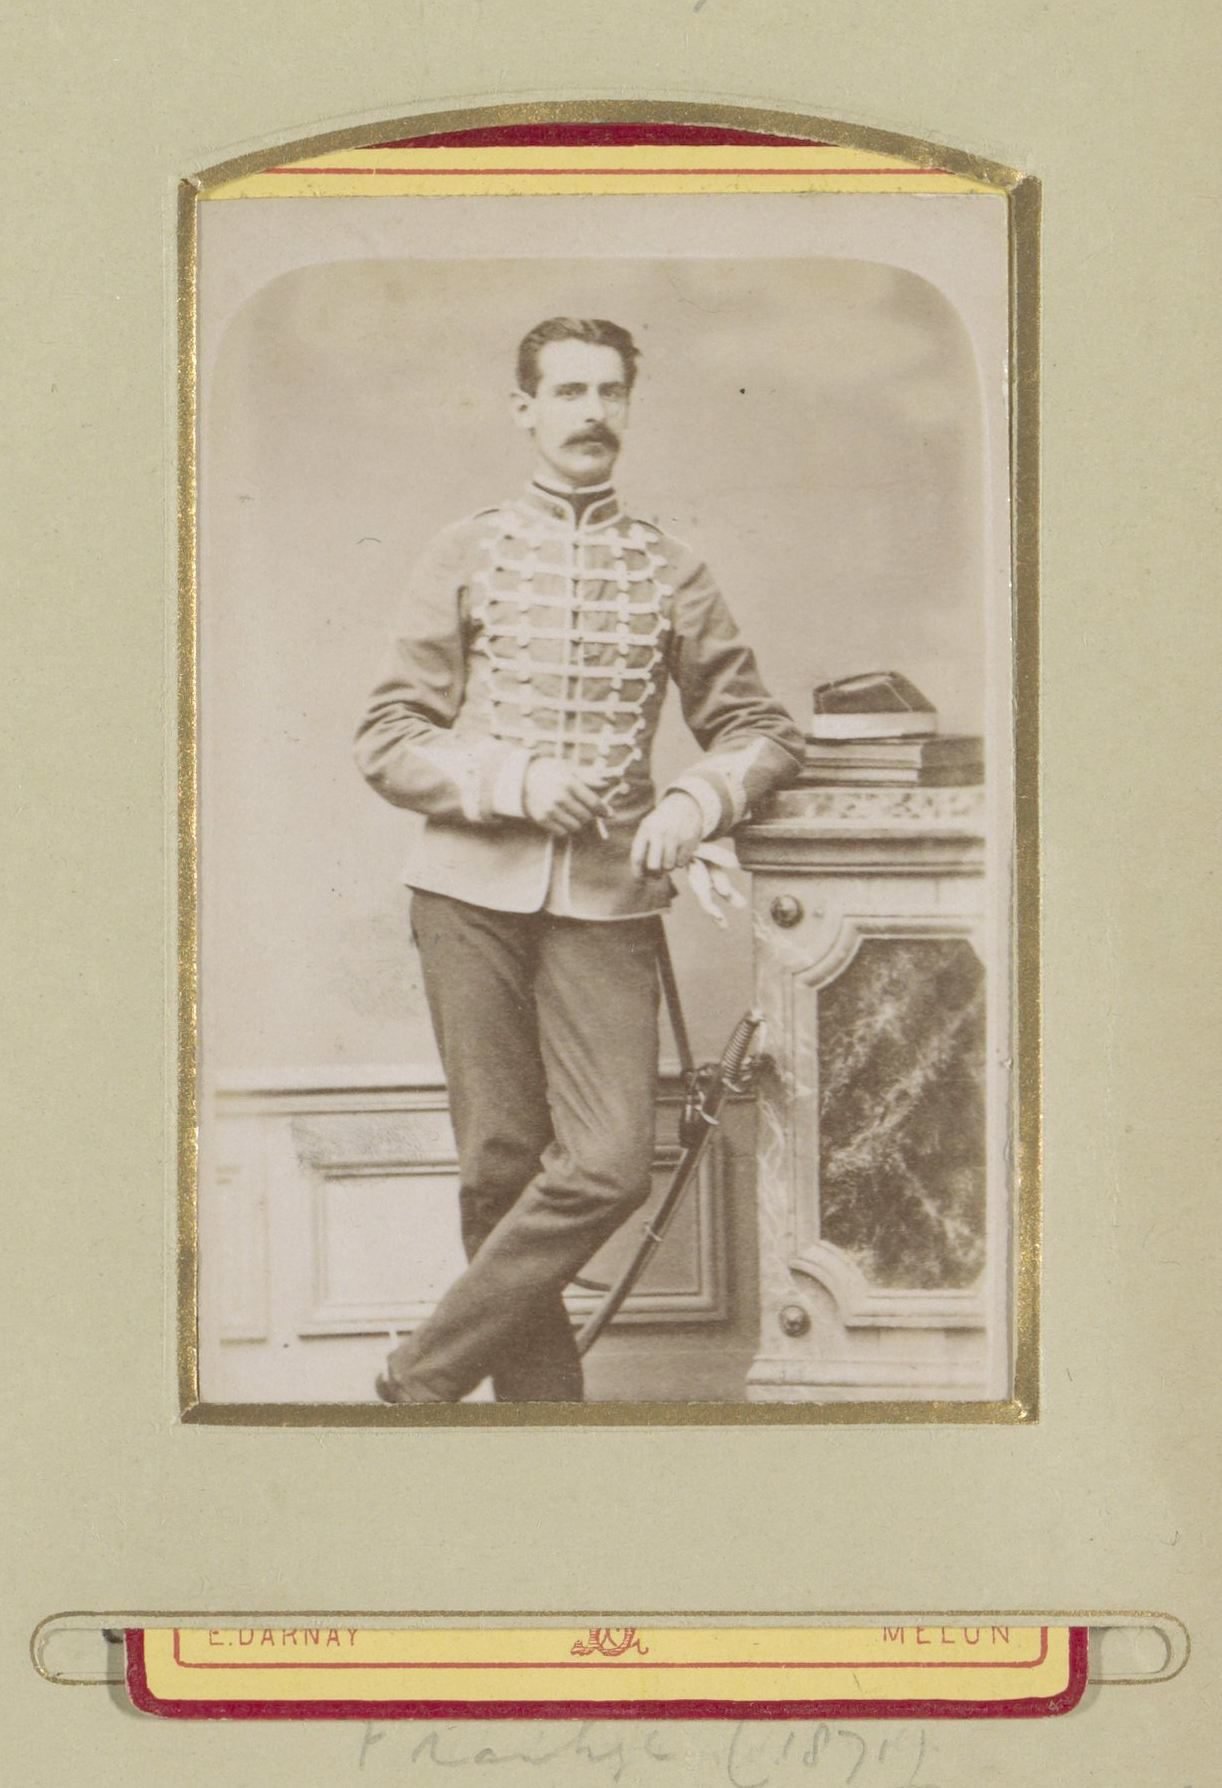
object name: photograph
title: Portret van een (vermoedelijk) Franse militair, staand in uniformjas met tressen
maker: eugène darnay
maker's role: painter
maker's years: 1831-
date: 1870-1900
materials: cardboard, paper, photographic support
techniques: albumen print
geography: melun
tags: studio requisites ~ photographer, warfare; military affairs, (military) uniforms, division of armed forces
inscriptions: address: ‘49, Avenue Thiers 49, Melun’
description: Onderdeel van Album met cartes-de-visite en kabinetfoto's van militairen in uniform.